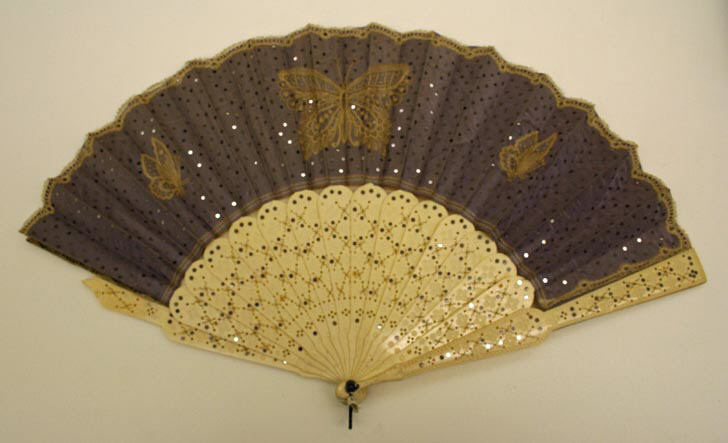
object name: fan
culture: american or european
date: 1870-1879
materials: ivory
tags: butterflies